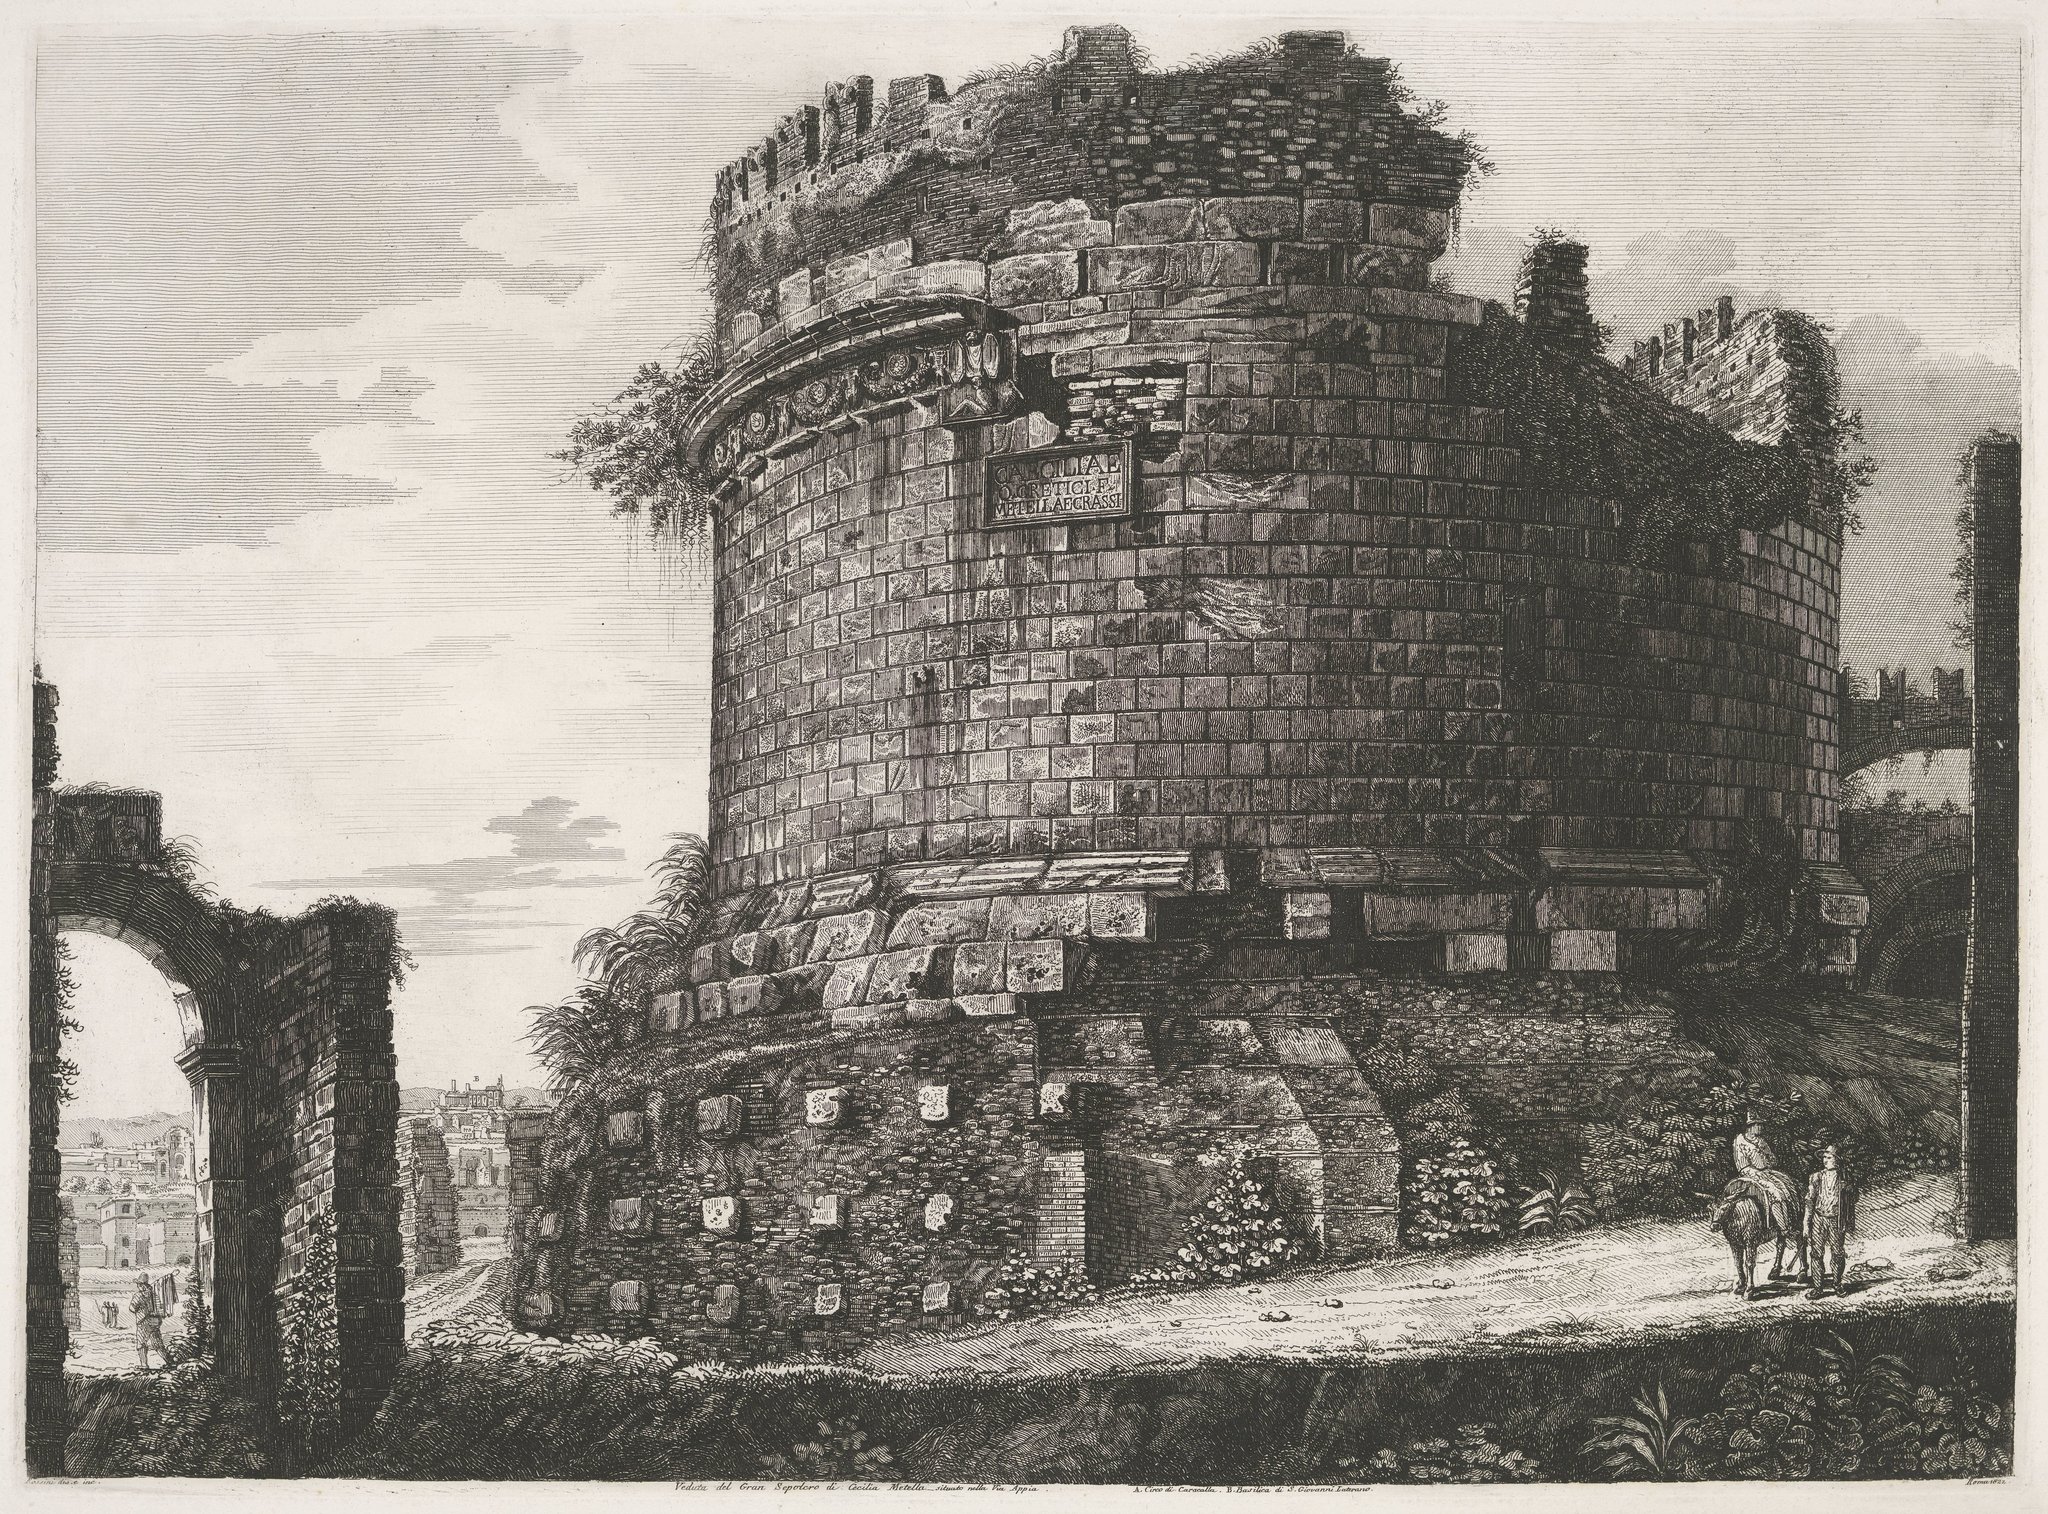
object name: print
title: Tombe van Caecilia Metella te Rome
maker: luigi rossini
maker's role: print maker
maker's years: 1790-1857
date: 1822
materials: paper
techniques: etching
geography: rome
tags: ruin of a building ~ architecture, landscape with ruins, grave, tomb, rome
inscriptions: collector's mark: Lugt 2228, collector's mark: Lugt 2760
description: Gezicht op de ruïnes van de Tombe van Caecilia Metella aan de Via Appia Antica te Rome.